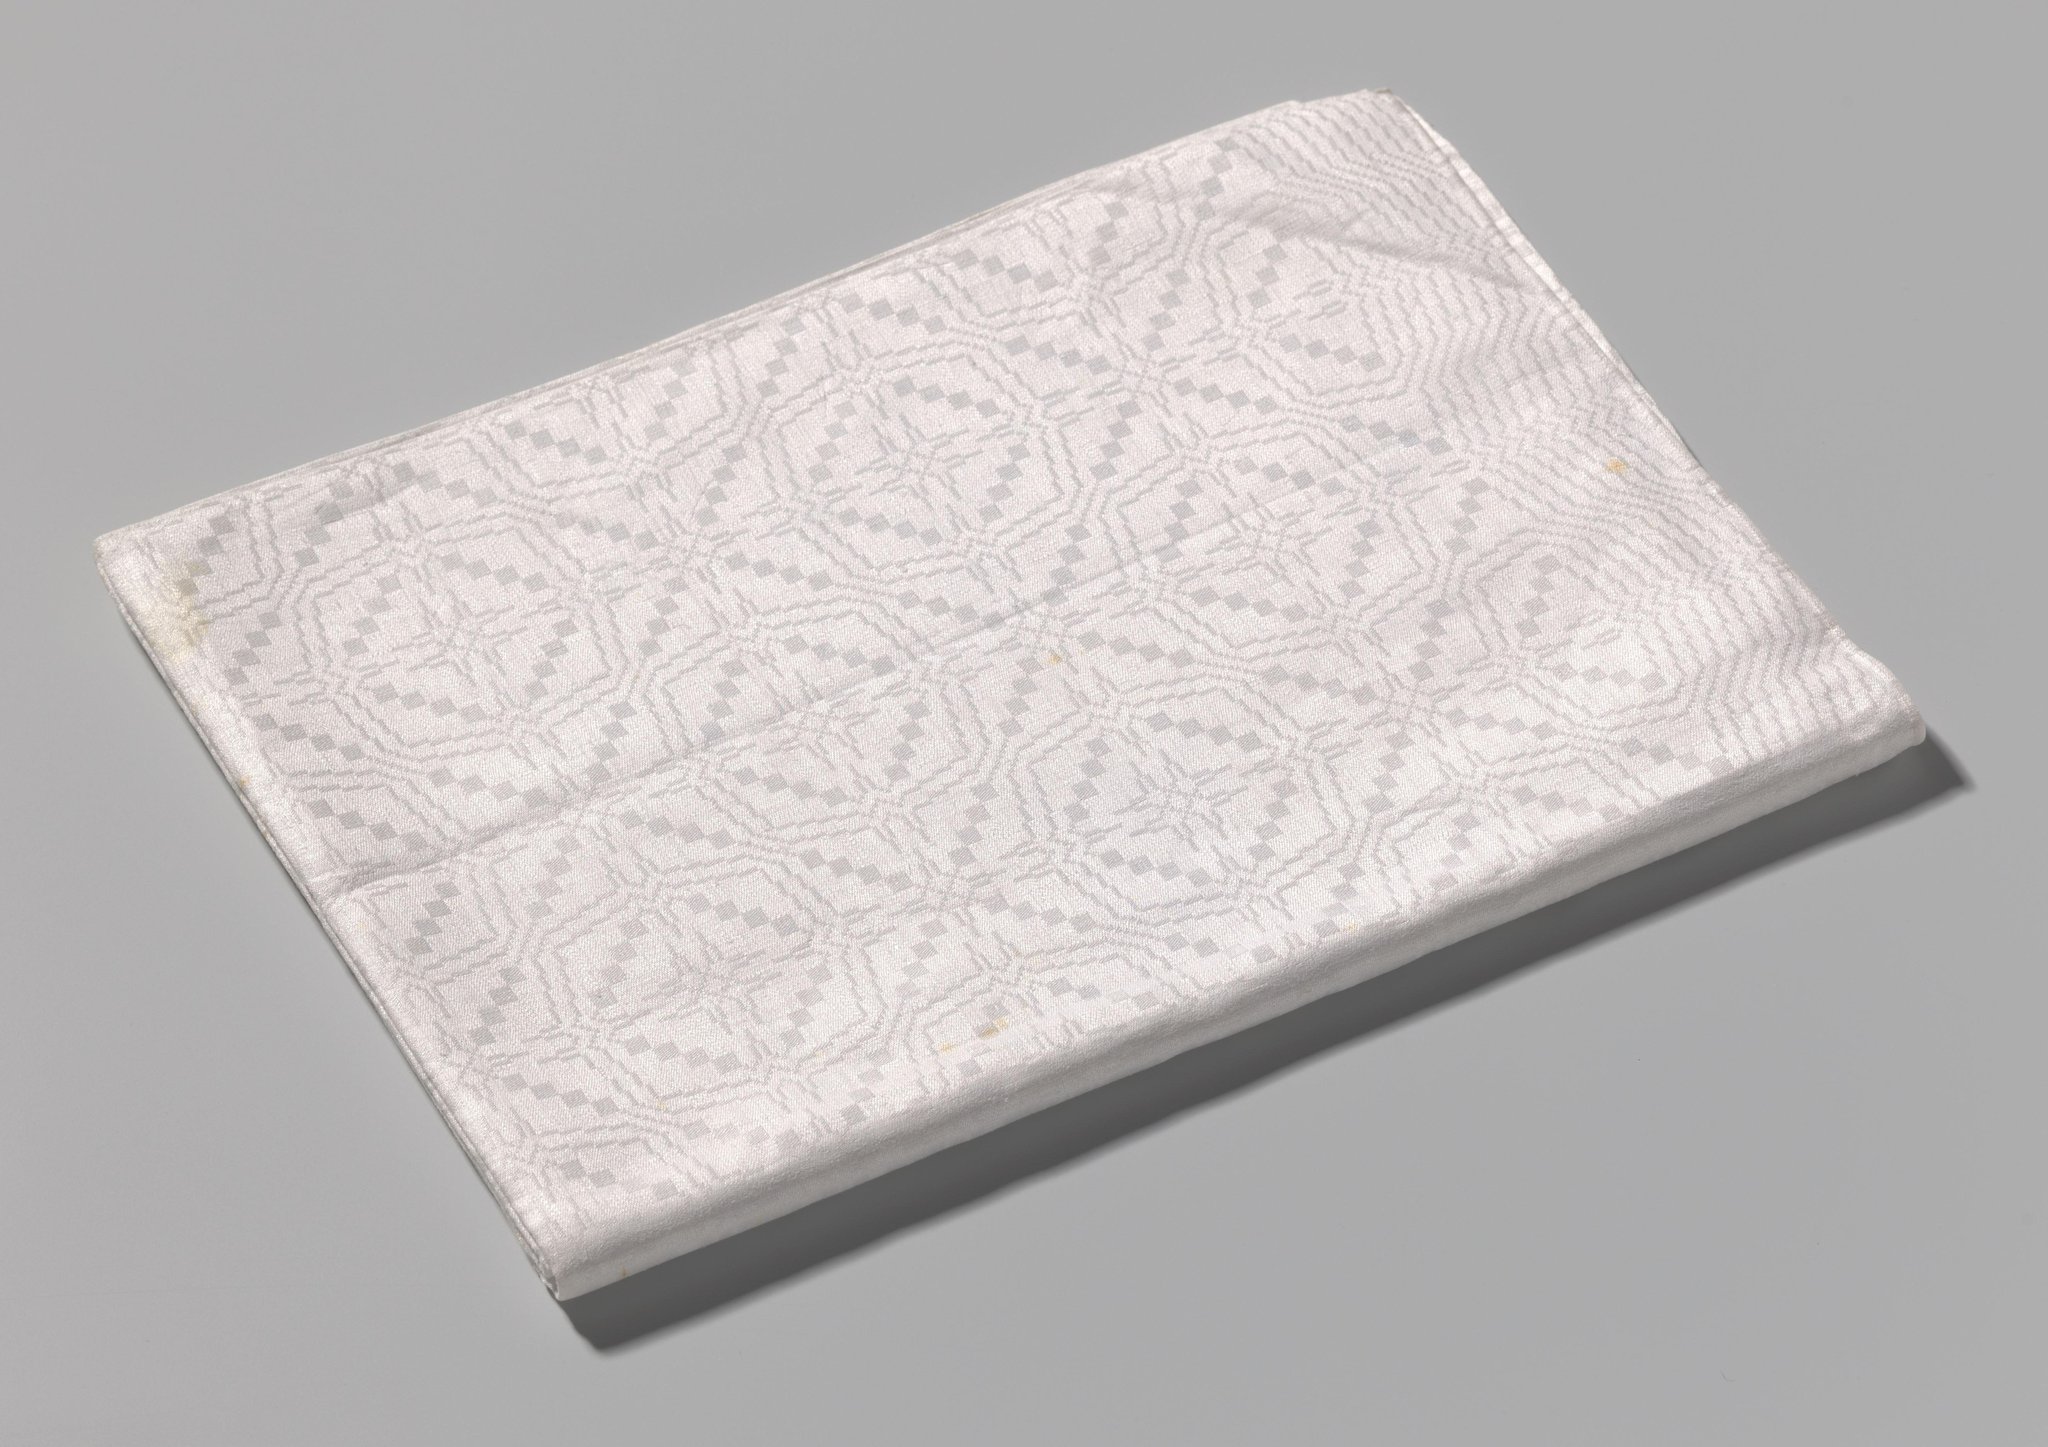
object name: handdwaal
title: Handdwaal van wit linnen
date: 1775-1799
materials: linen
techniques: peeled fabric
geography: netherlands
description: Wit linnen handdwaal met een pellen patroon en randen, merk HW 3 en kroon HW 3 p poonl.